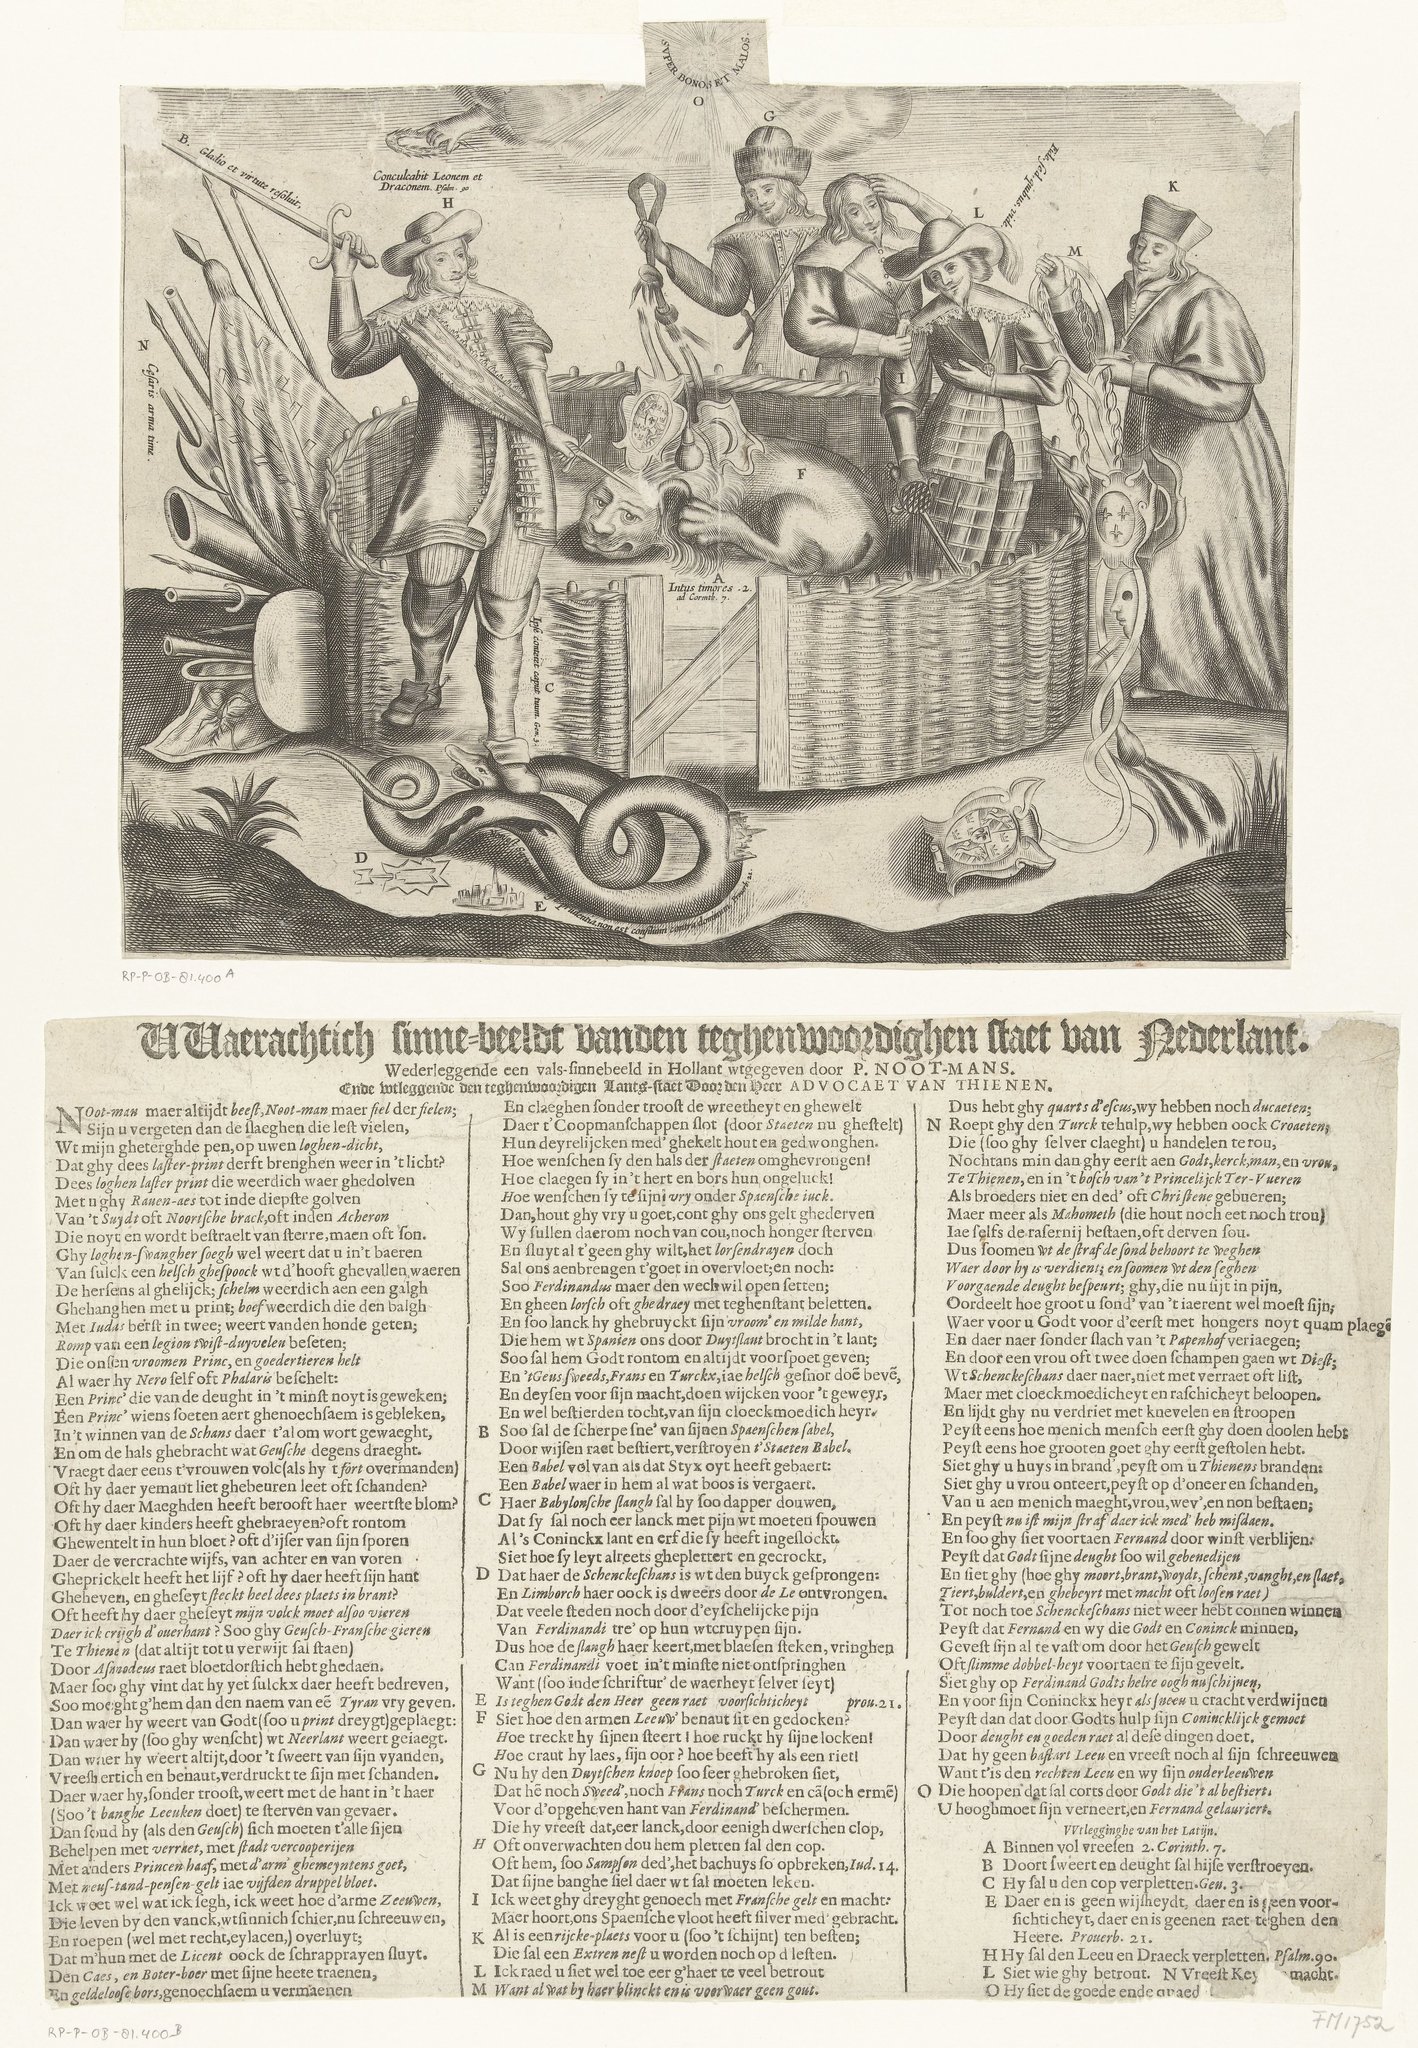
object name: text sheet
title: Waerachtich sinne-beelt vanden teghenwoordighen staet van Nederlant. Wederleggende een vals-sinnebeeld in Hollant wtgegeven door P. Noot-mans. Ende wtleggende den teghenwoordigen Lants-staet Door den heer advocaet van Thienen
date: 1636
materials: paper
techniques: letterpress printing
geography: southern netherlands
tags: the hague, frederick henry (prince of orange), paris, armand-jean du plessis hertog van richelieu, landvoogd der zuidelijke nederlanden ferdinand van oostenrijk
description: Tekstblad behorend bij de allegorie tegen Frederik Hendrik in het jaar 1636. De prent is een antwoord op FMH 1751.